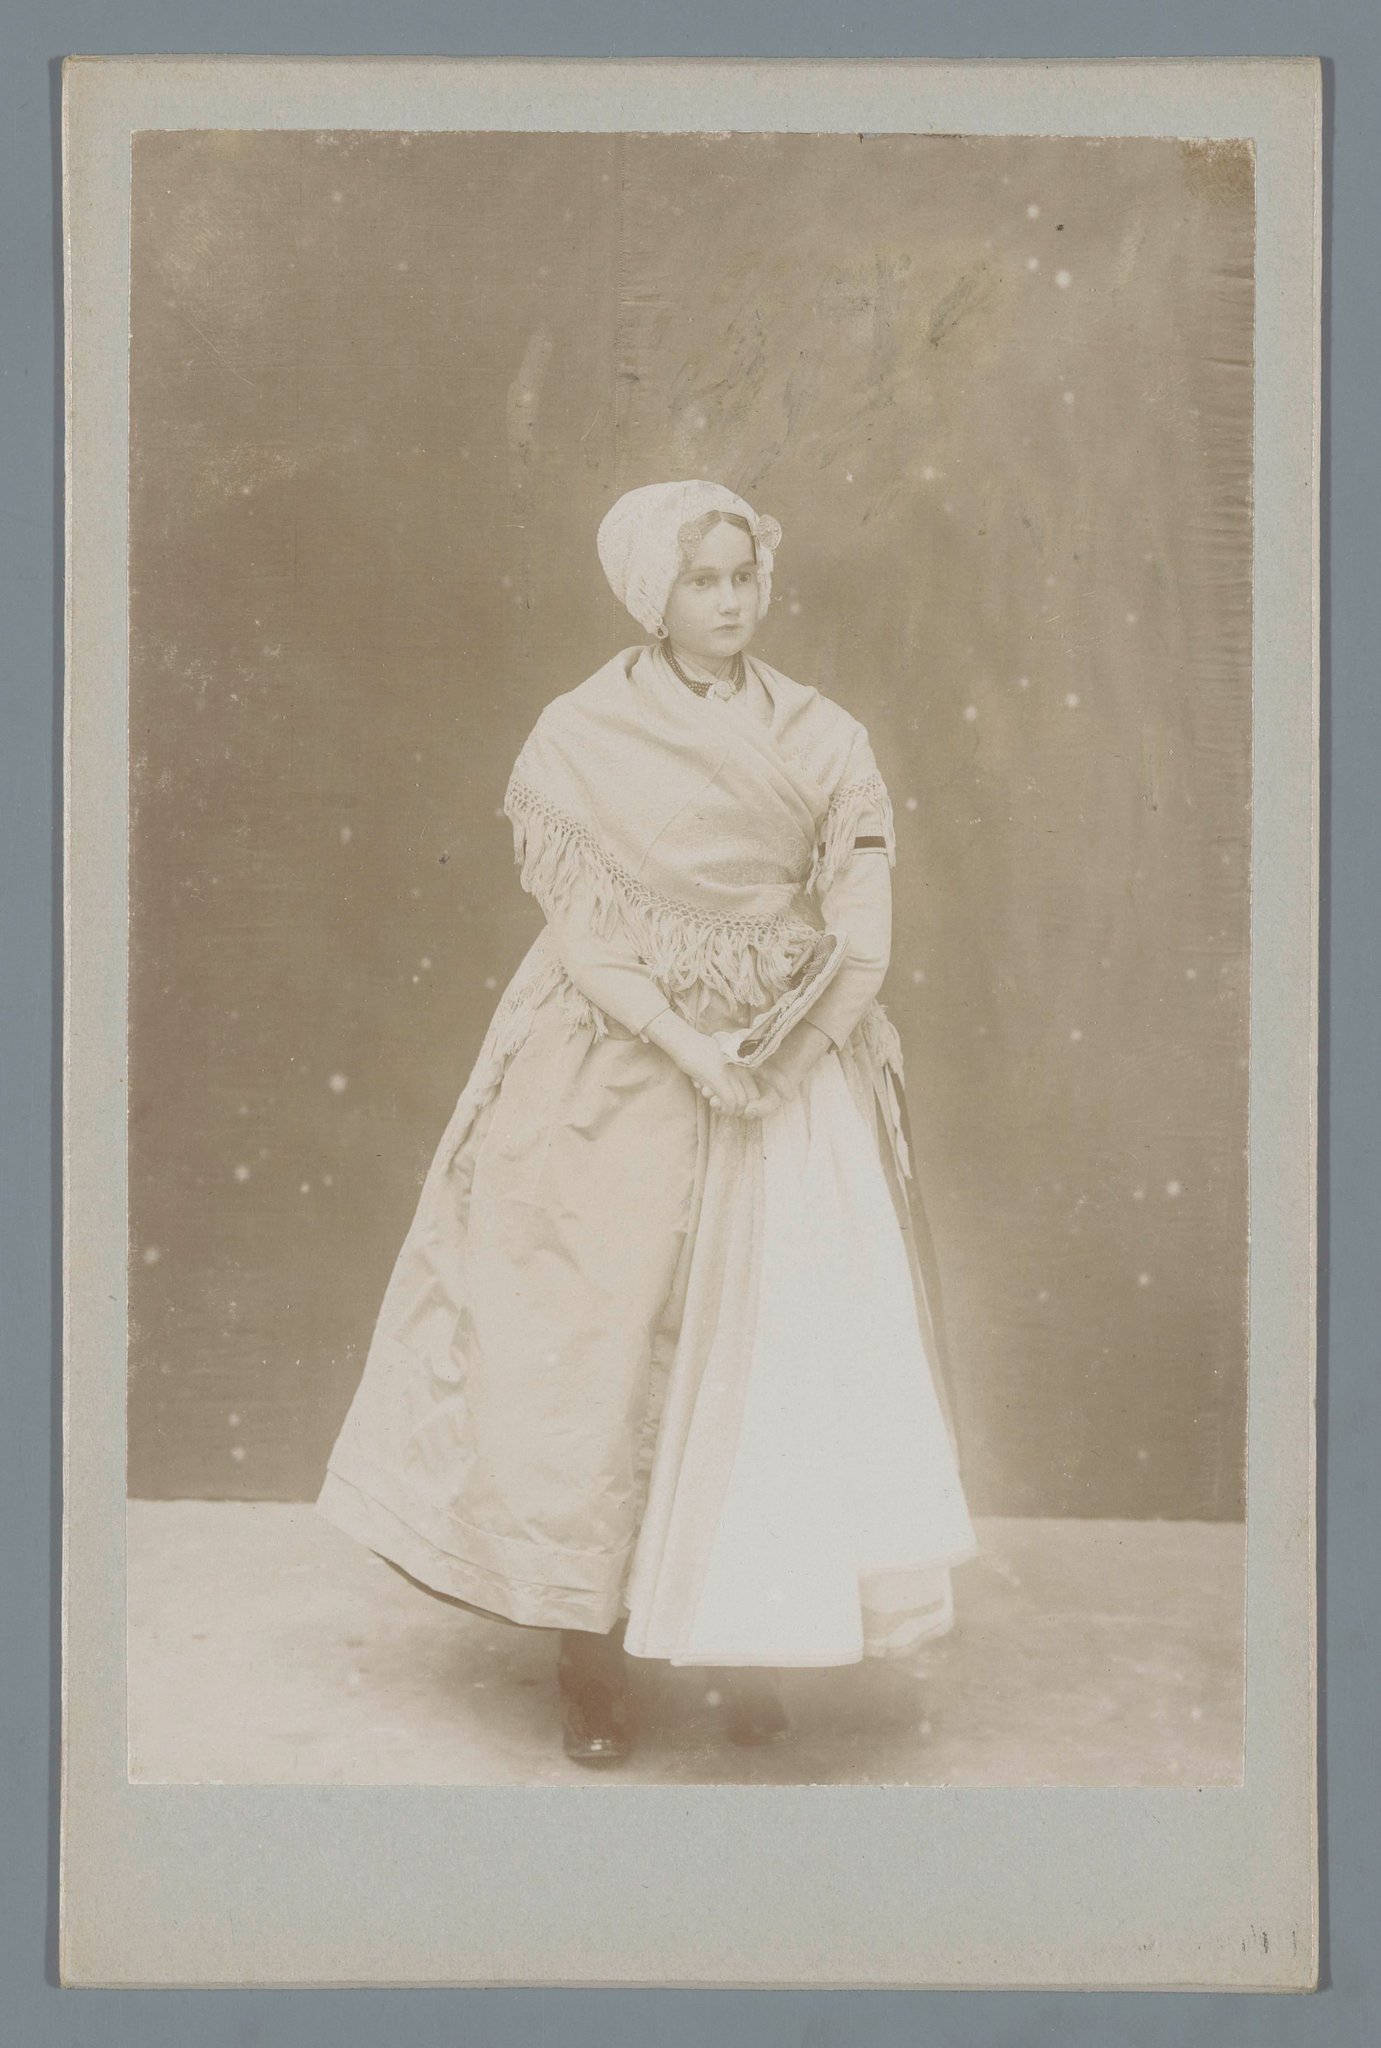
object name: cabinet photograph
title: Pop in klederdracht van vermoedelijk van Scheveningen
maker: Anonymous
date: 1880-1900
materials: cardboard, photographic support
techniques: collodion silver print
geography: netherlands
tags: (playing with) dolls, folk costume, regional costume